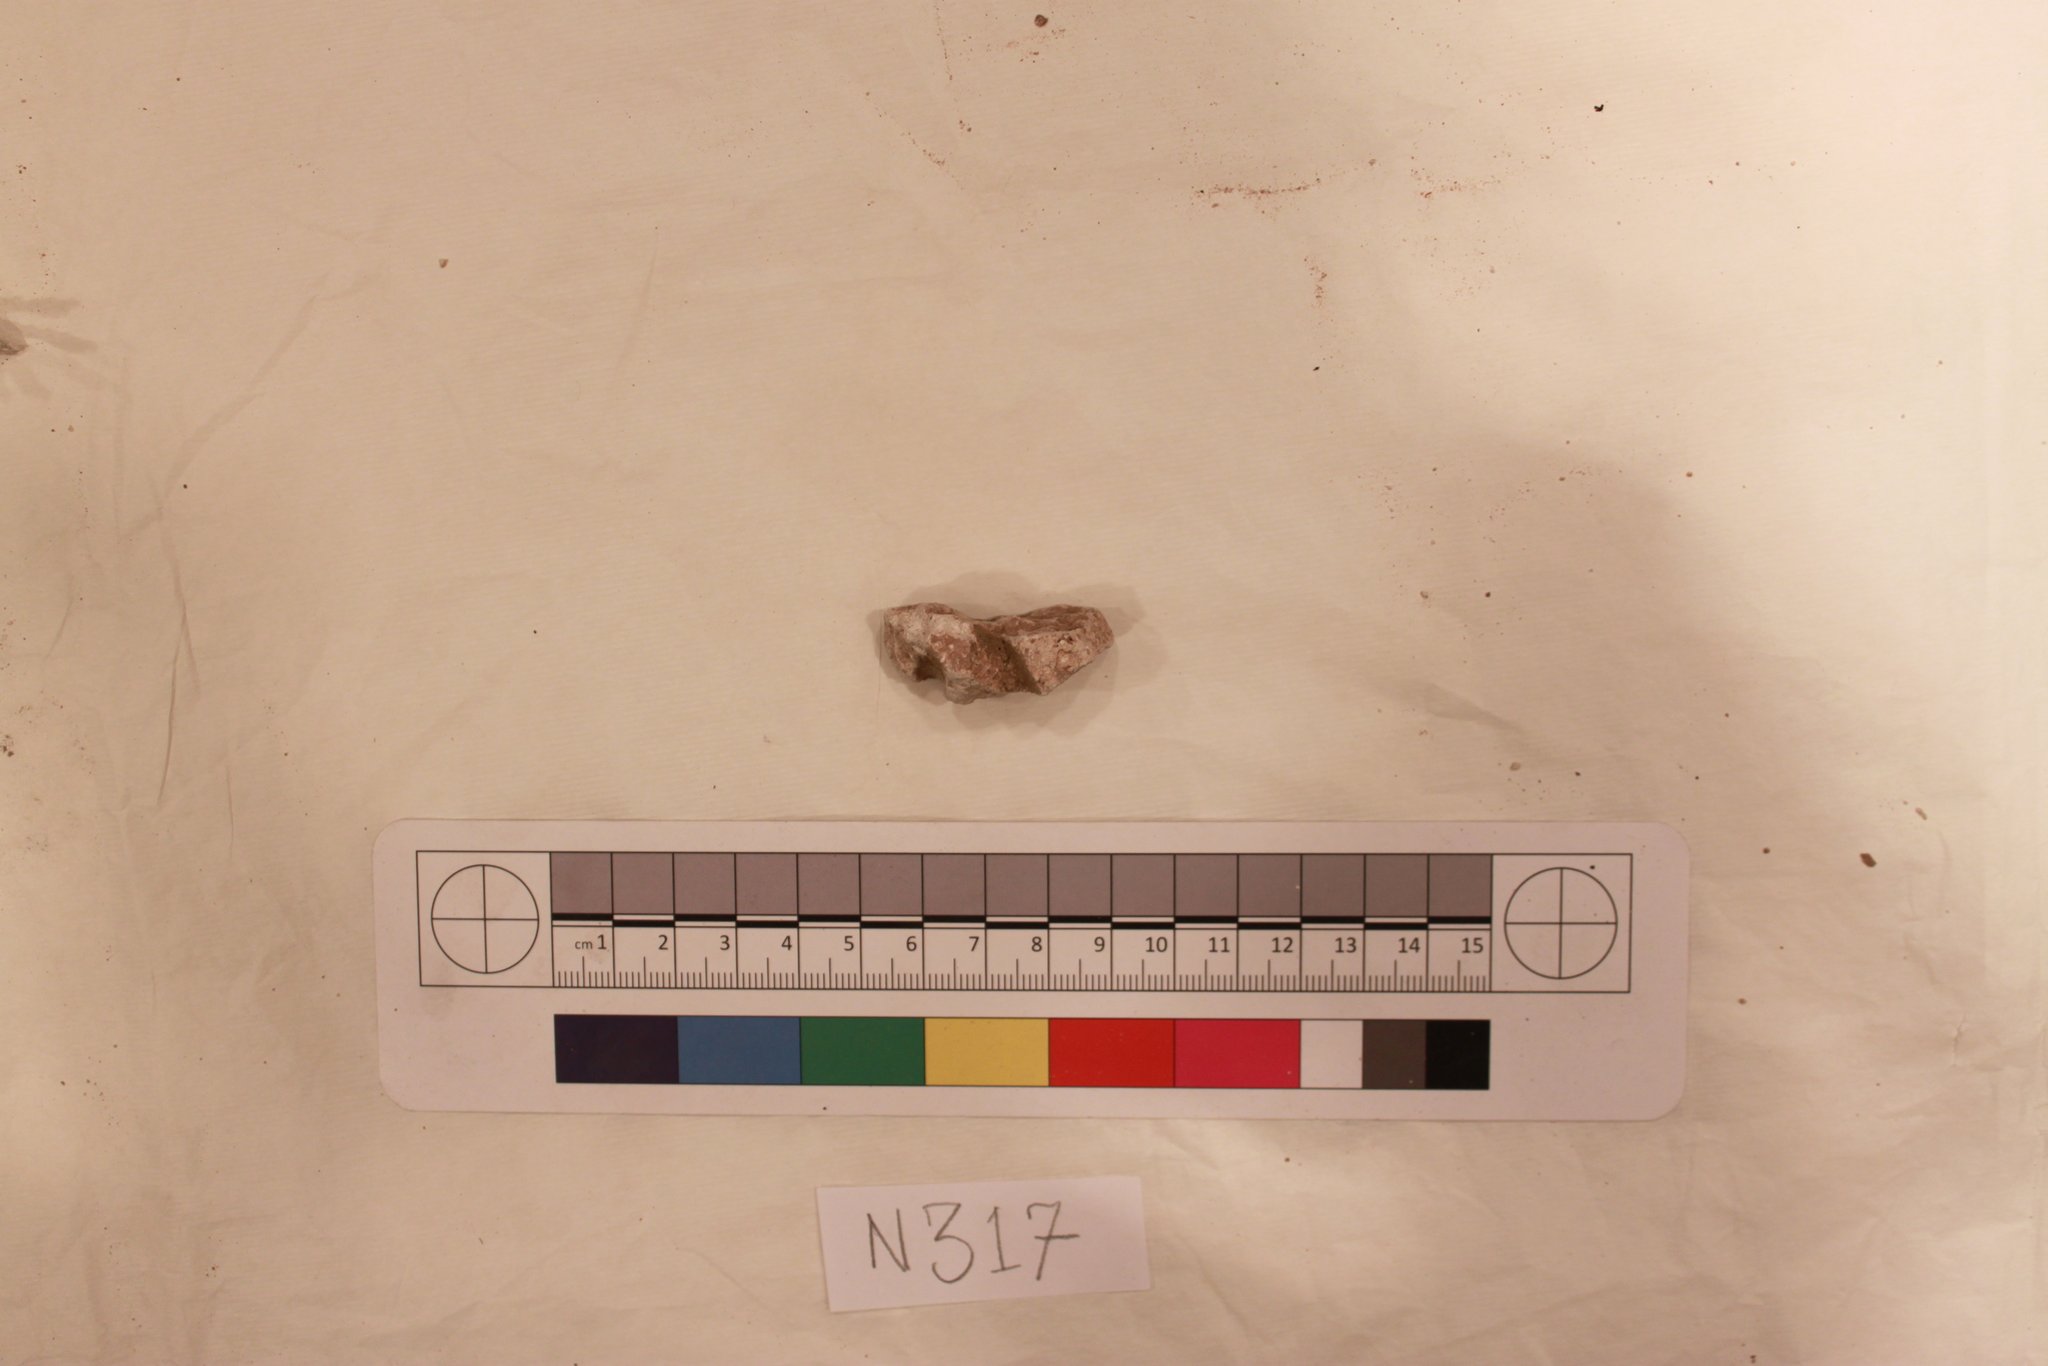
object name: fragment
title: Stucco Fragment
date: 701-1200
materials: plaster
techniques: carving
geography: iran